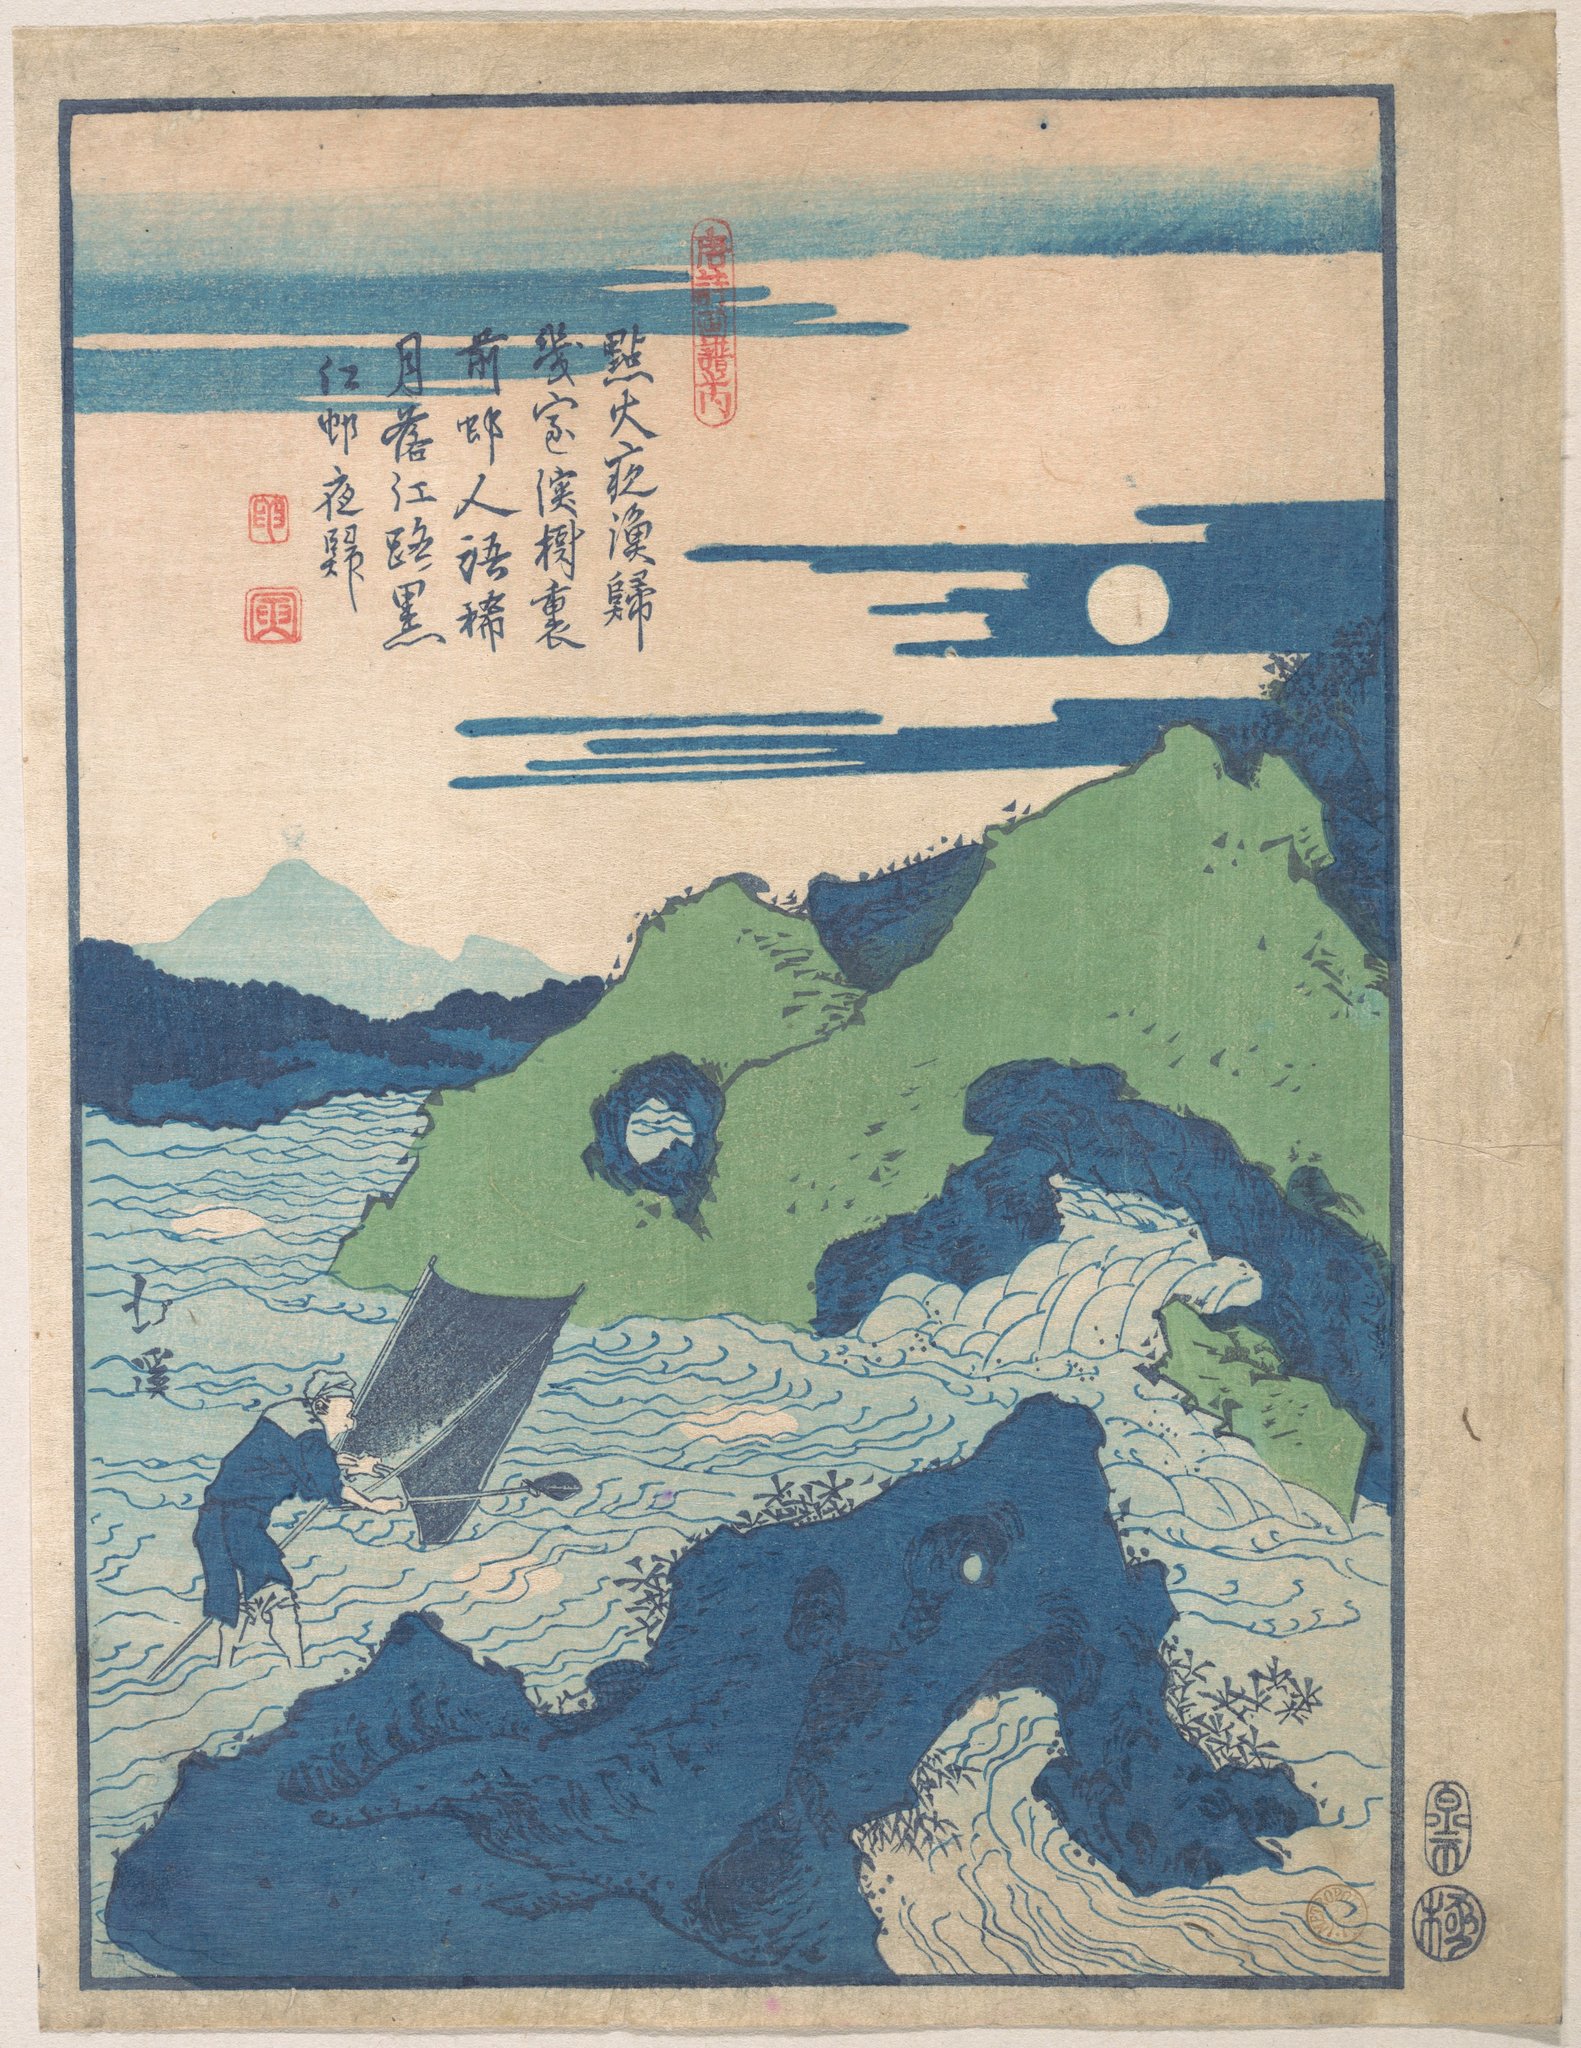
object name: woodblock print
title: A Fisherman is Struggling amid the Rocks and Currents of an Inlet of the Sea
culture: japanese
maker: totoya hokkei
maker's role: artist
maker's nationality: japanese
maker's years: 1780-1850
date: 1780-1850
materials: ink, paper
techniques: woodblock print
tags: men,fishing,mountains